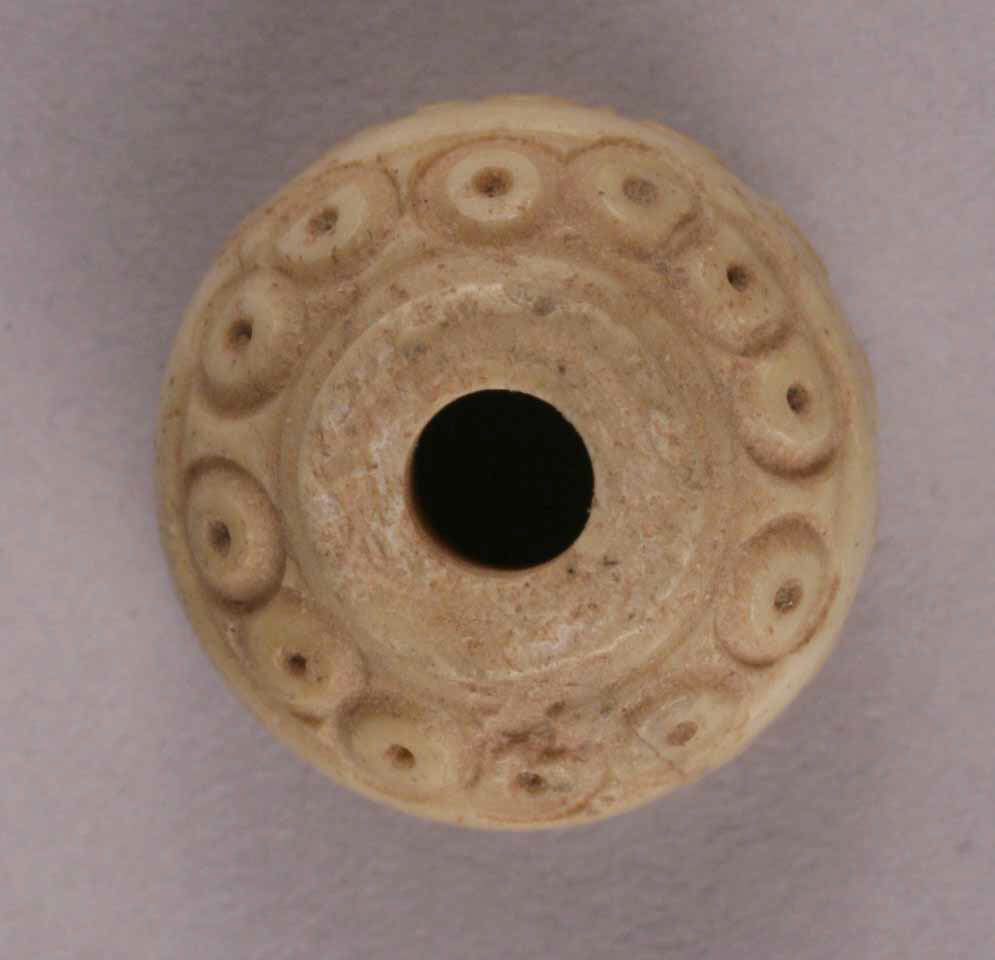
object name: spindle whorl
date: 801-1000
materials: bone, paint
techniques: incising, inlay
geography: iran